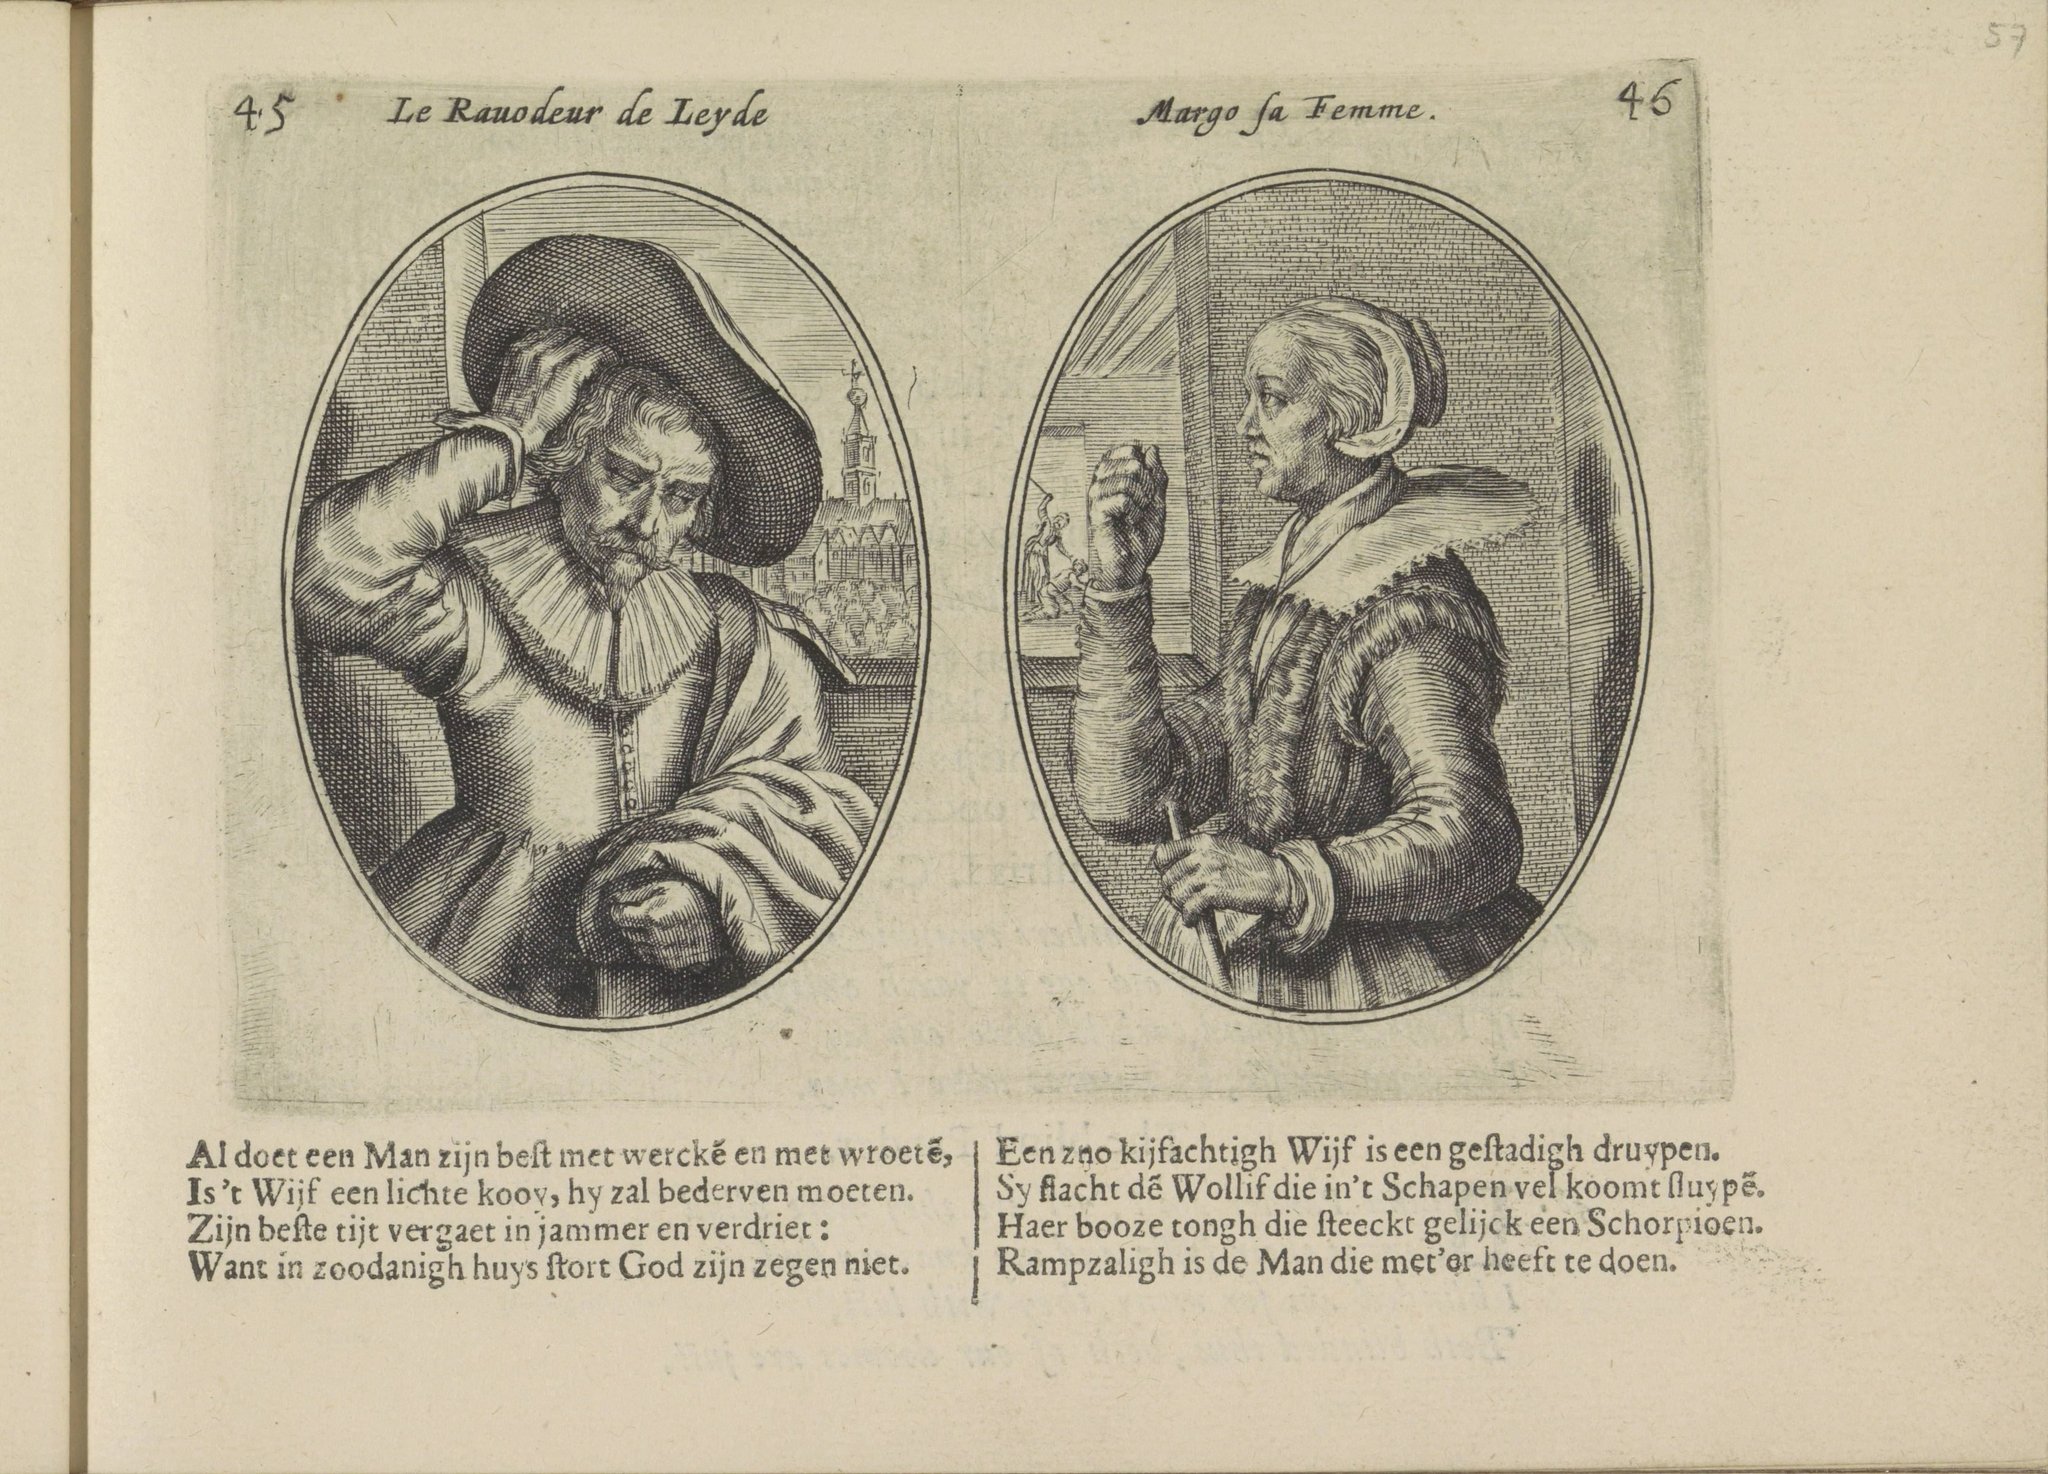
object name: print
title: Les abus du mariage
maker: crispijn van de passe (ii)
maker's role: draughtsman, print maker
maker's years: 1594-1670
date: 1641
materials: paper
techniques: engraving, letterpress printing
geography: amsterdam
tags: city-view, and landscape with man-made constructions, scratching one's head, female sex; woman, dominating wife, male sex; man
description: Twee voorstellingen op een albumblad. Links een lapsnijder, dat is een kleermaker die geen nieuw goed maakt. Hij krabt aan zijn hoofd. Op de achtergrond een stadsgezicht, mogelijk Leiden. Rechts zijn vrouw. In de verte slaat de vrouw haar man met een stok. Daaronder twee kwatrijnen in het Nederlands. De prent maakt deel uit van een album.